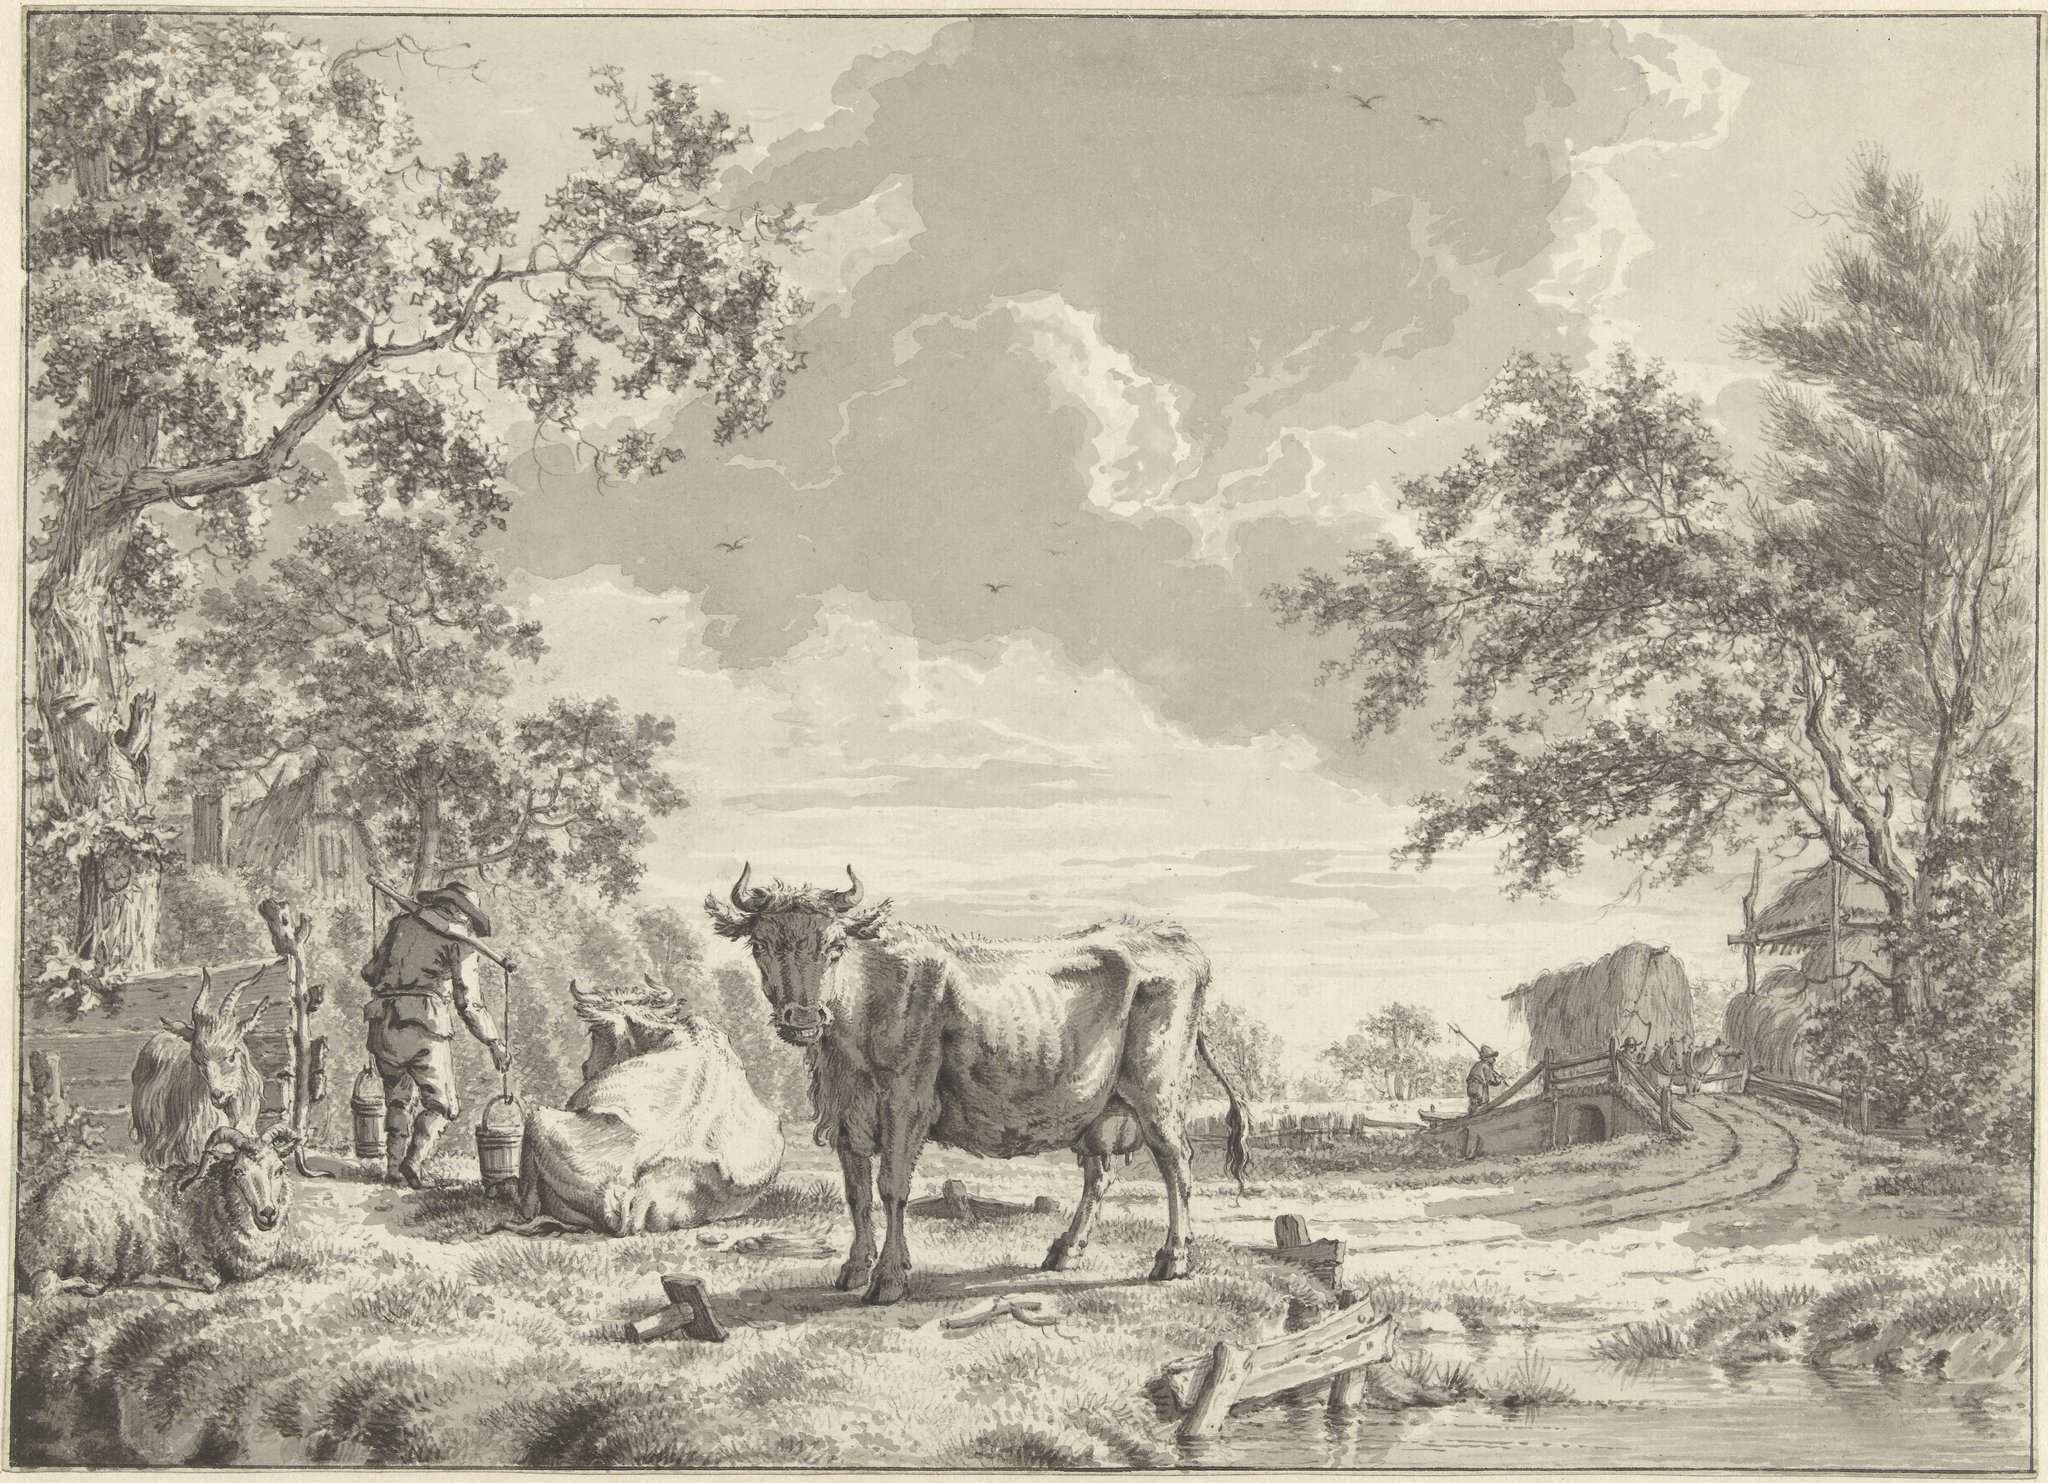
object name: drawing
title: Landschap met vee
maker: johannes jelgerhuis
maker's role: draughtsman, painter, print maker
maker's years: 1770-1836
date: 1787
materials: chalk, paper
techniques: brush